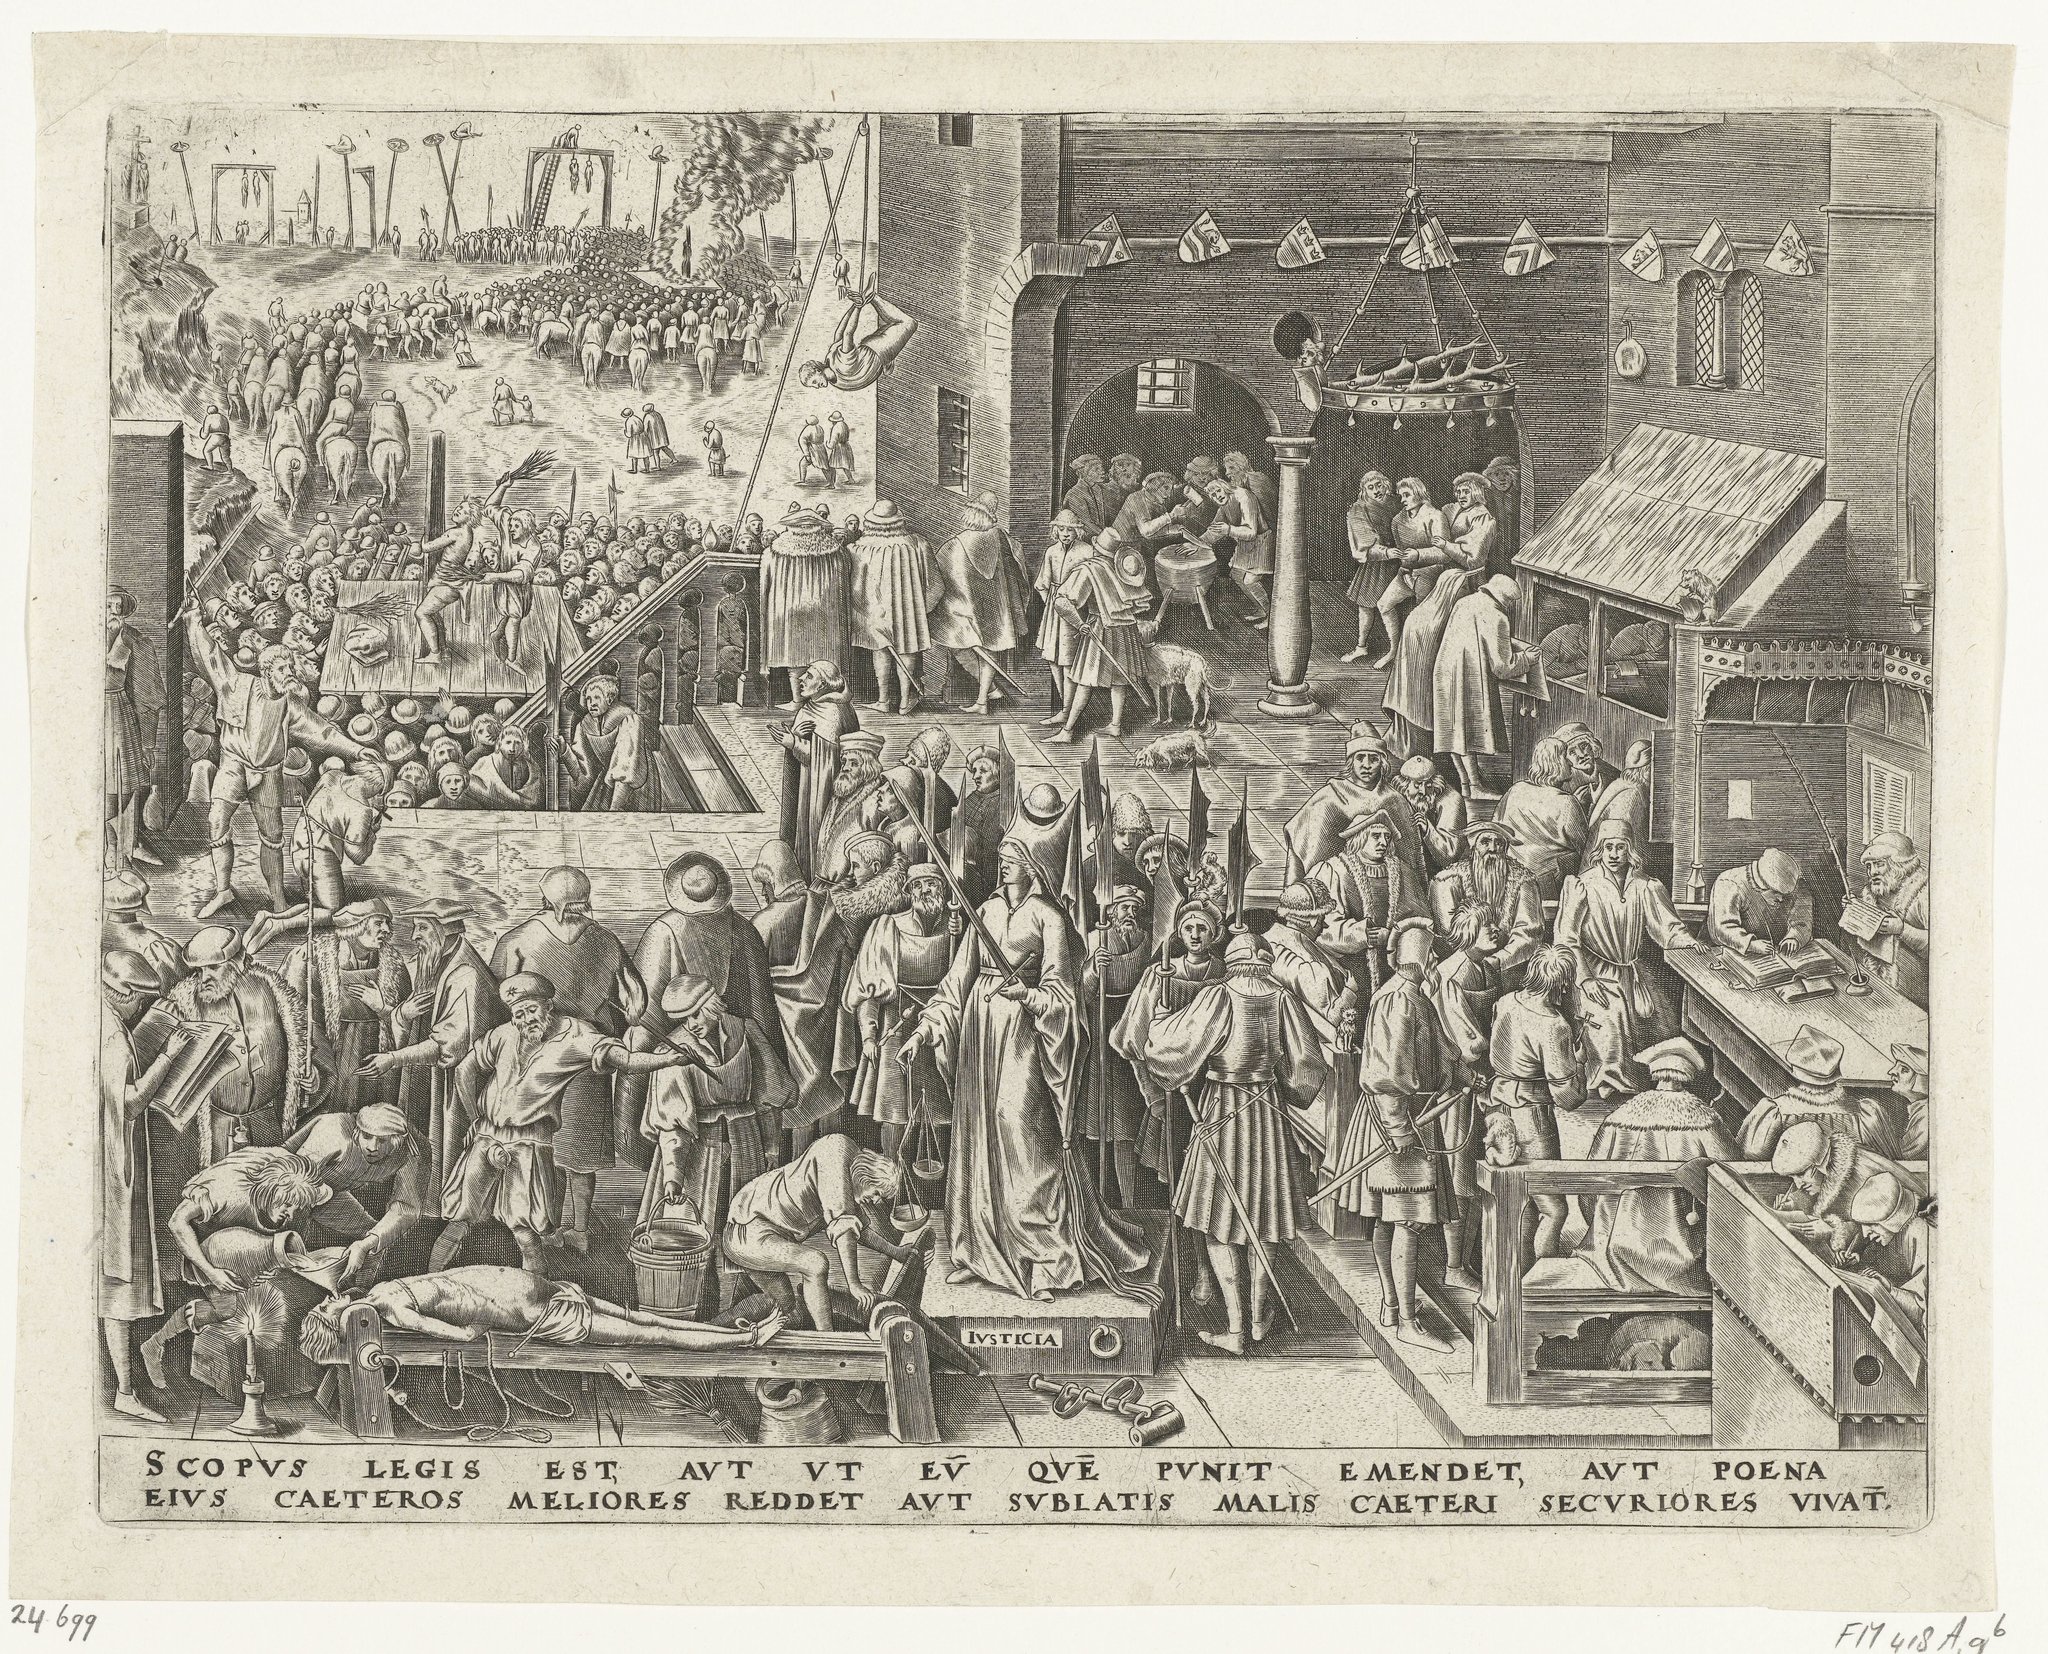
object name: print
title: Rechtvaardigheid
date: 1559-1560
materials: paper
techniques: engraving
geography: southern netherlands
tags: justice, 'justitia'; 'giustitia divina' (ripa) ~ one of the four cardinal virtues, law and jurisprudence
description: Vrouwelijke personificatie Justitia, geblinddoekt en met weegschalen en zwaard in de hand, staande op een plein omringd door allerlei scènes waarin de Rechtvaardigheid wordt geïllustreerd: aanklacht en uitspraak, verhoor, marteling en openbare terechtstelling. Met onderschrift van 2 regels in het Latijn.